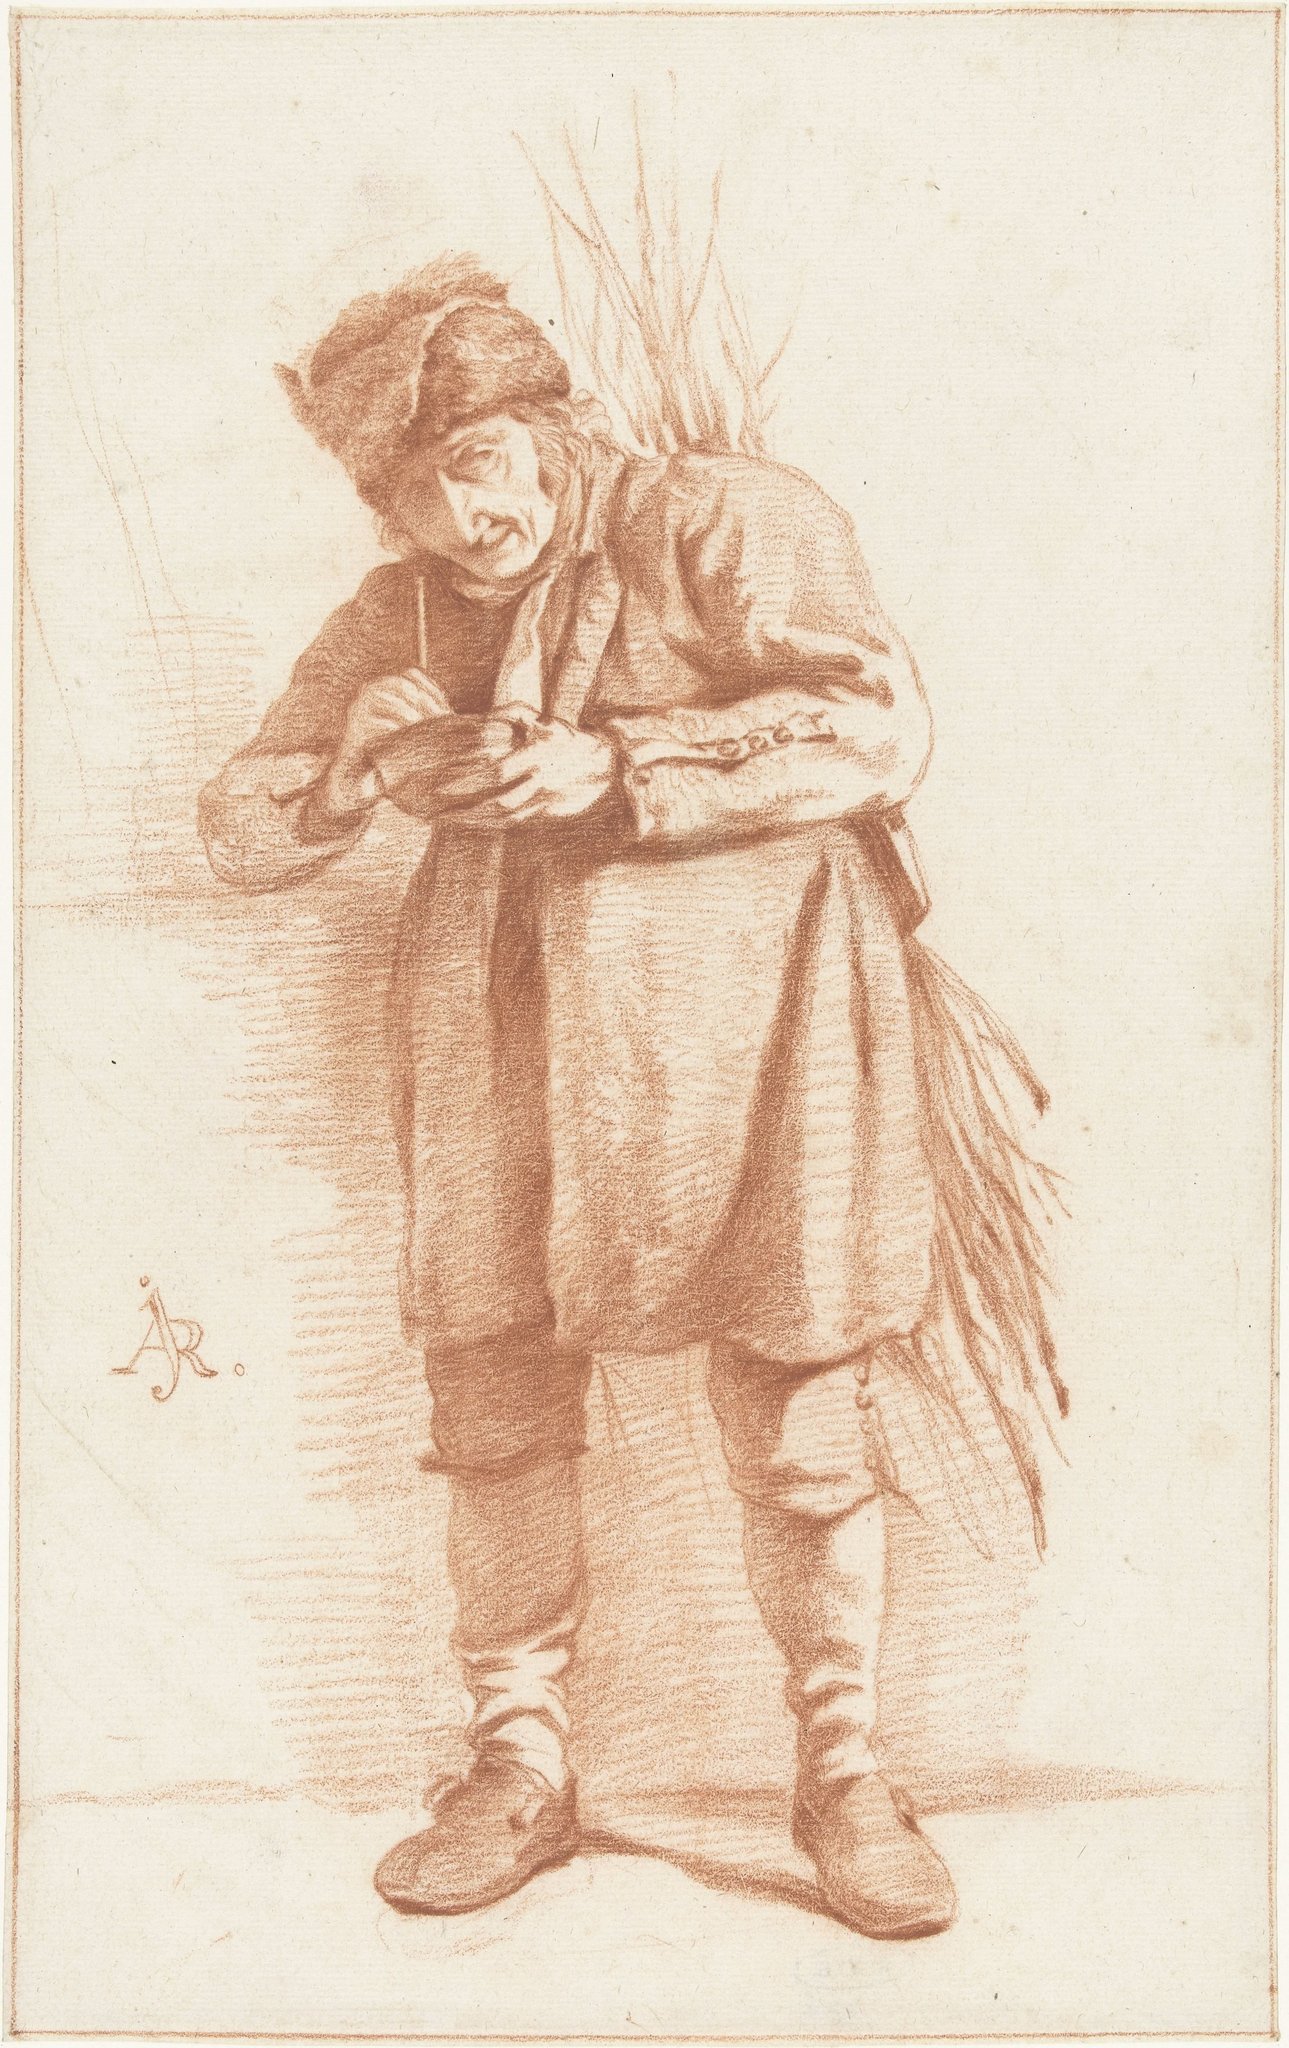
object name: drawing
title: Staande man met een pijp en een takkenbos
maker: abraham johannes ruytenschildt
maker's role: draughtsman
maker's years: 1778-1841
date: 1801-1811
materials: chalk, paper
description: Staande man met pijp in de hand en een takkenbos op de rug.